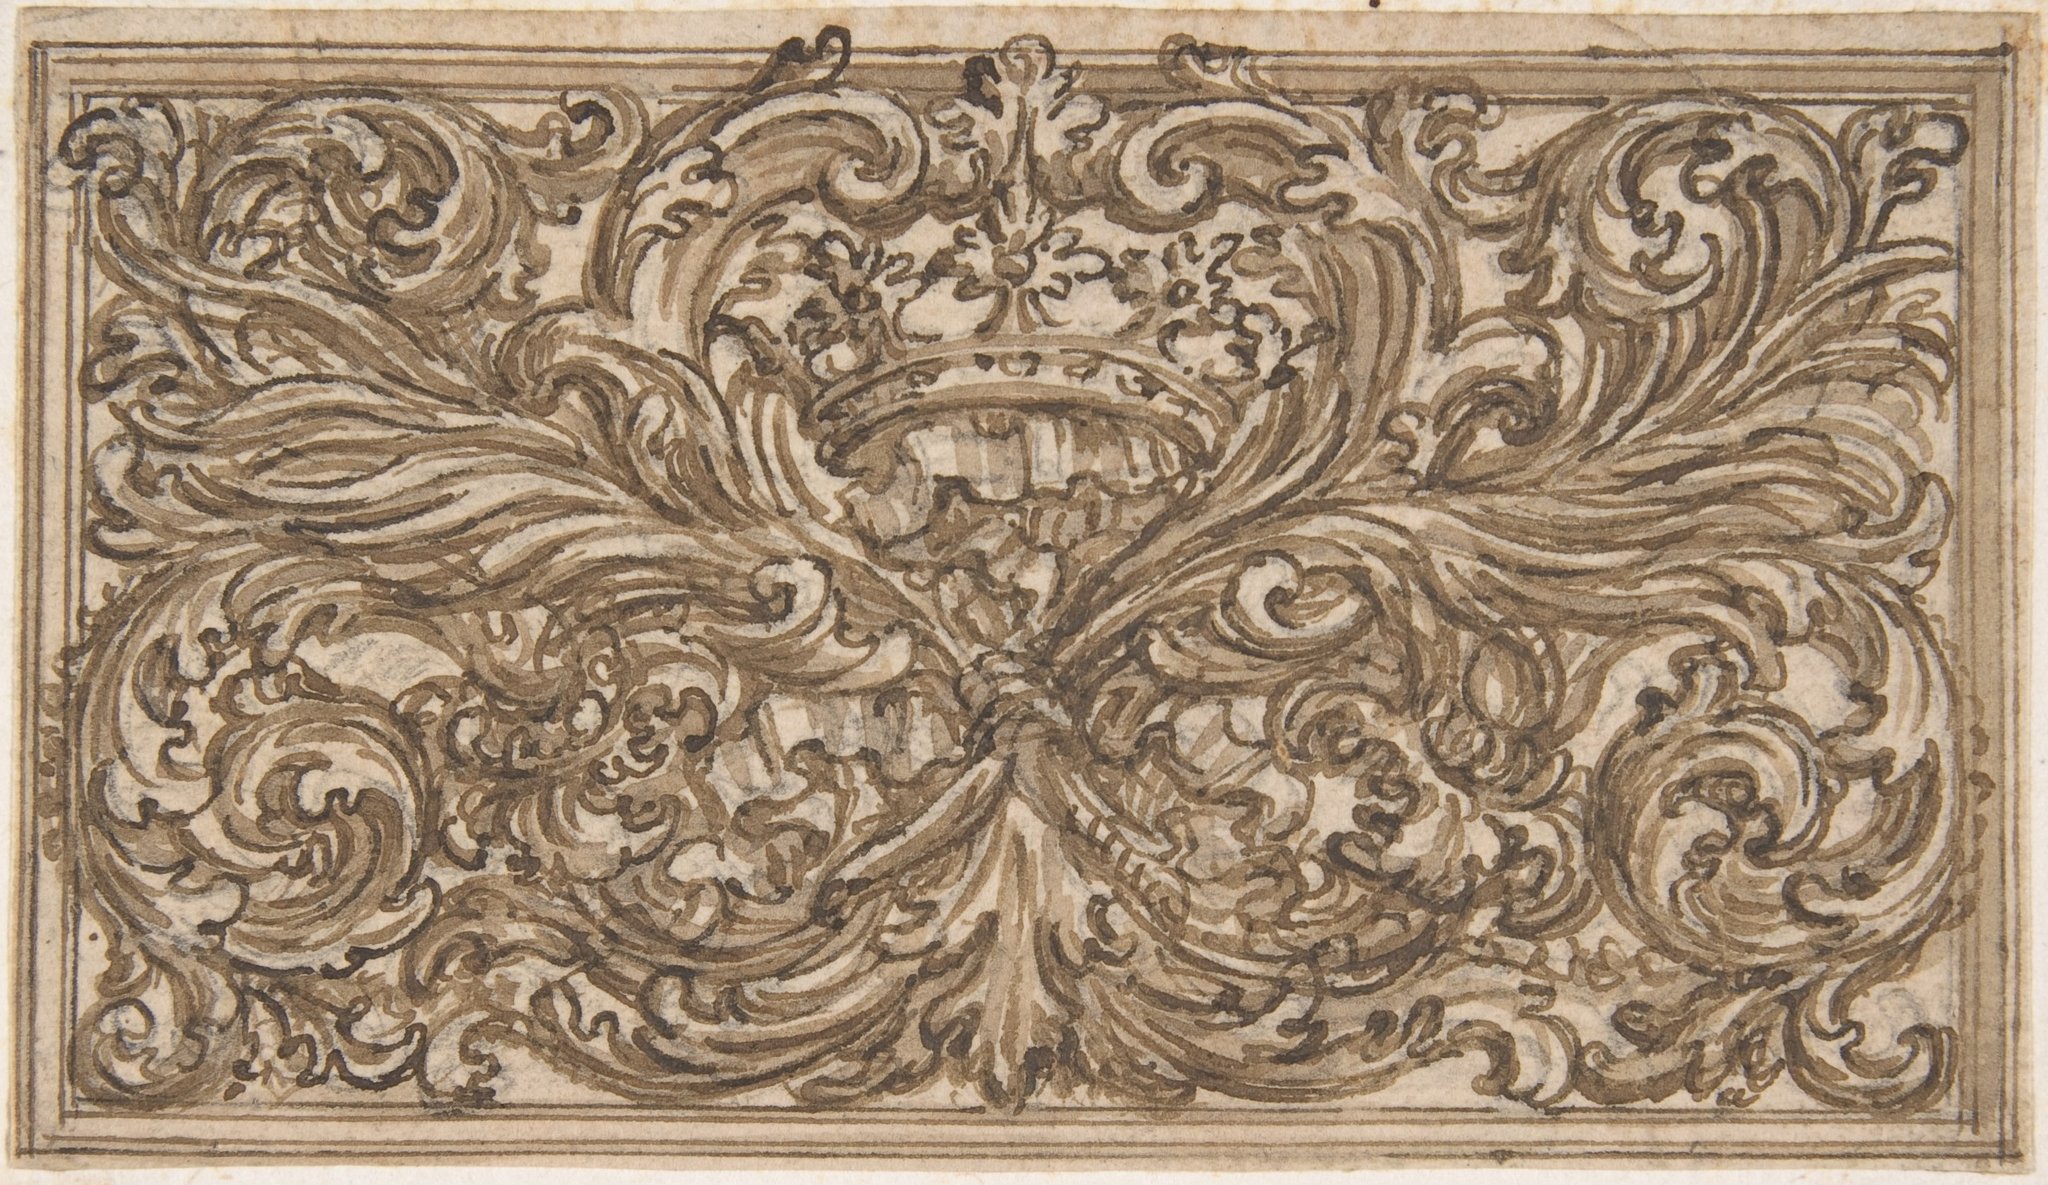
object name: drawing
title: Design for a Panel Decorated with A Bundle of Foliage, A Crown and a Shell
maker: anonymous, italian, 18th century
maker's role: artist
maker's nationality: italian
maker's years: 1700-1800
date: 1701-1800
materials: ink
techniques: pen, wash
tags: ornament